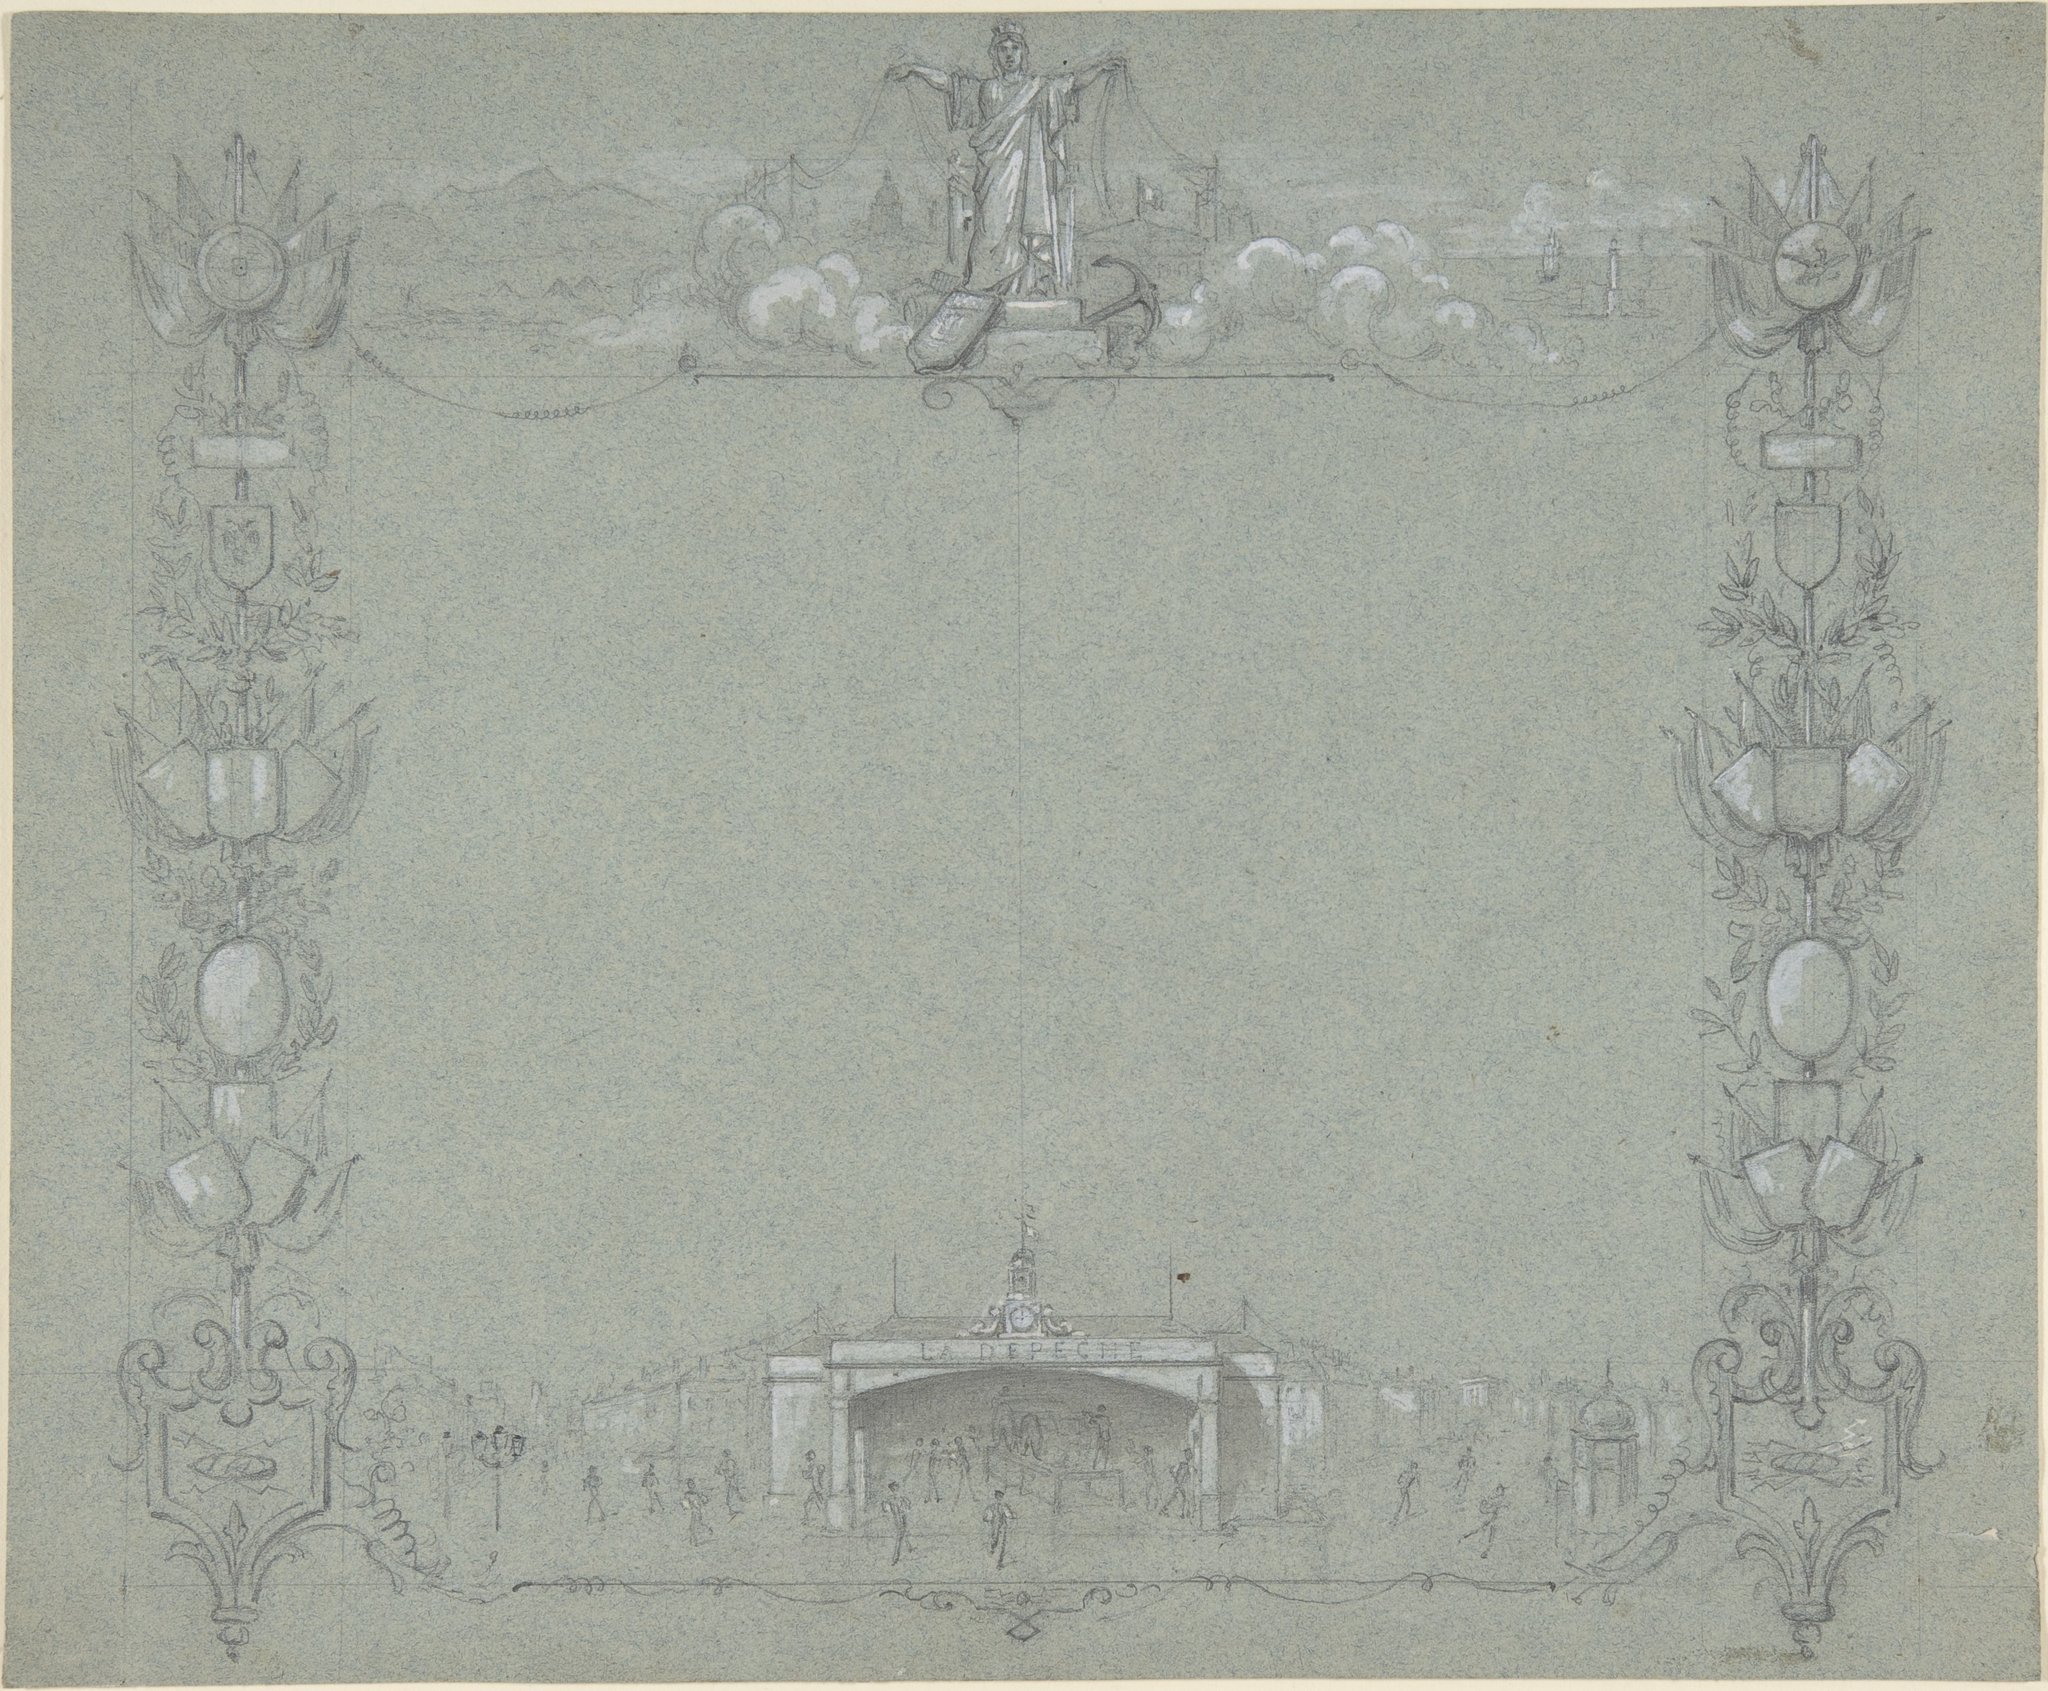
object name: drawing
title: Design for a Certificate(?) sponsored by the French newspaper, La Dépêche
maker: la dépêche (the dispatch)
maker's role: dedicatee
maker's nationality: french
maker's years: 1800-1900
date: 1801-1900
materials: graphite, paper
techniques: heightening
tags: human figures,architecture